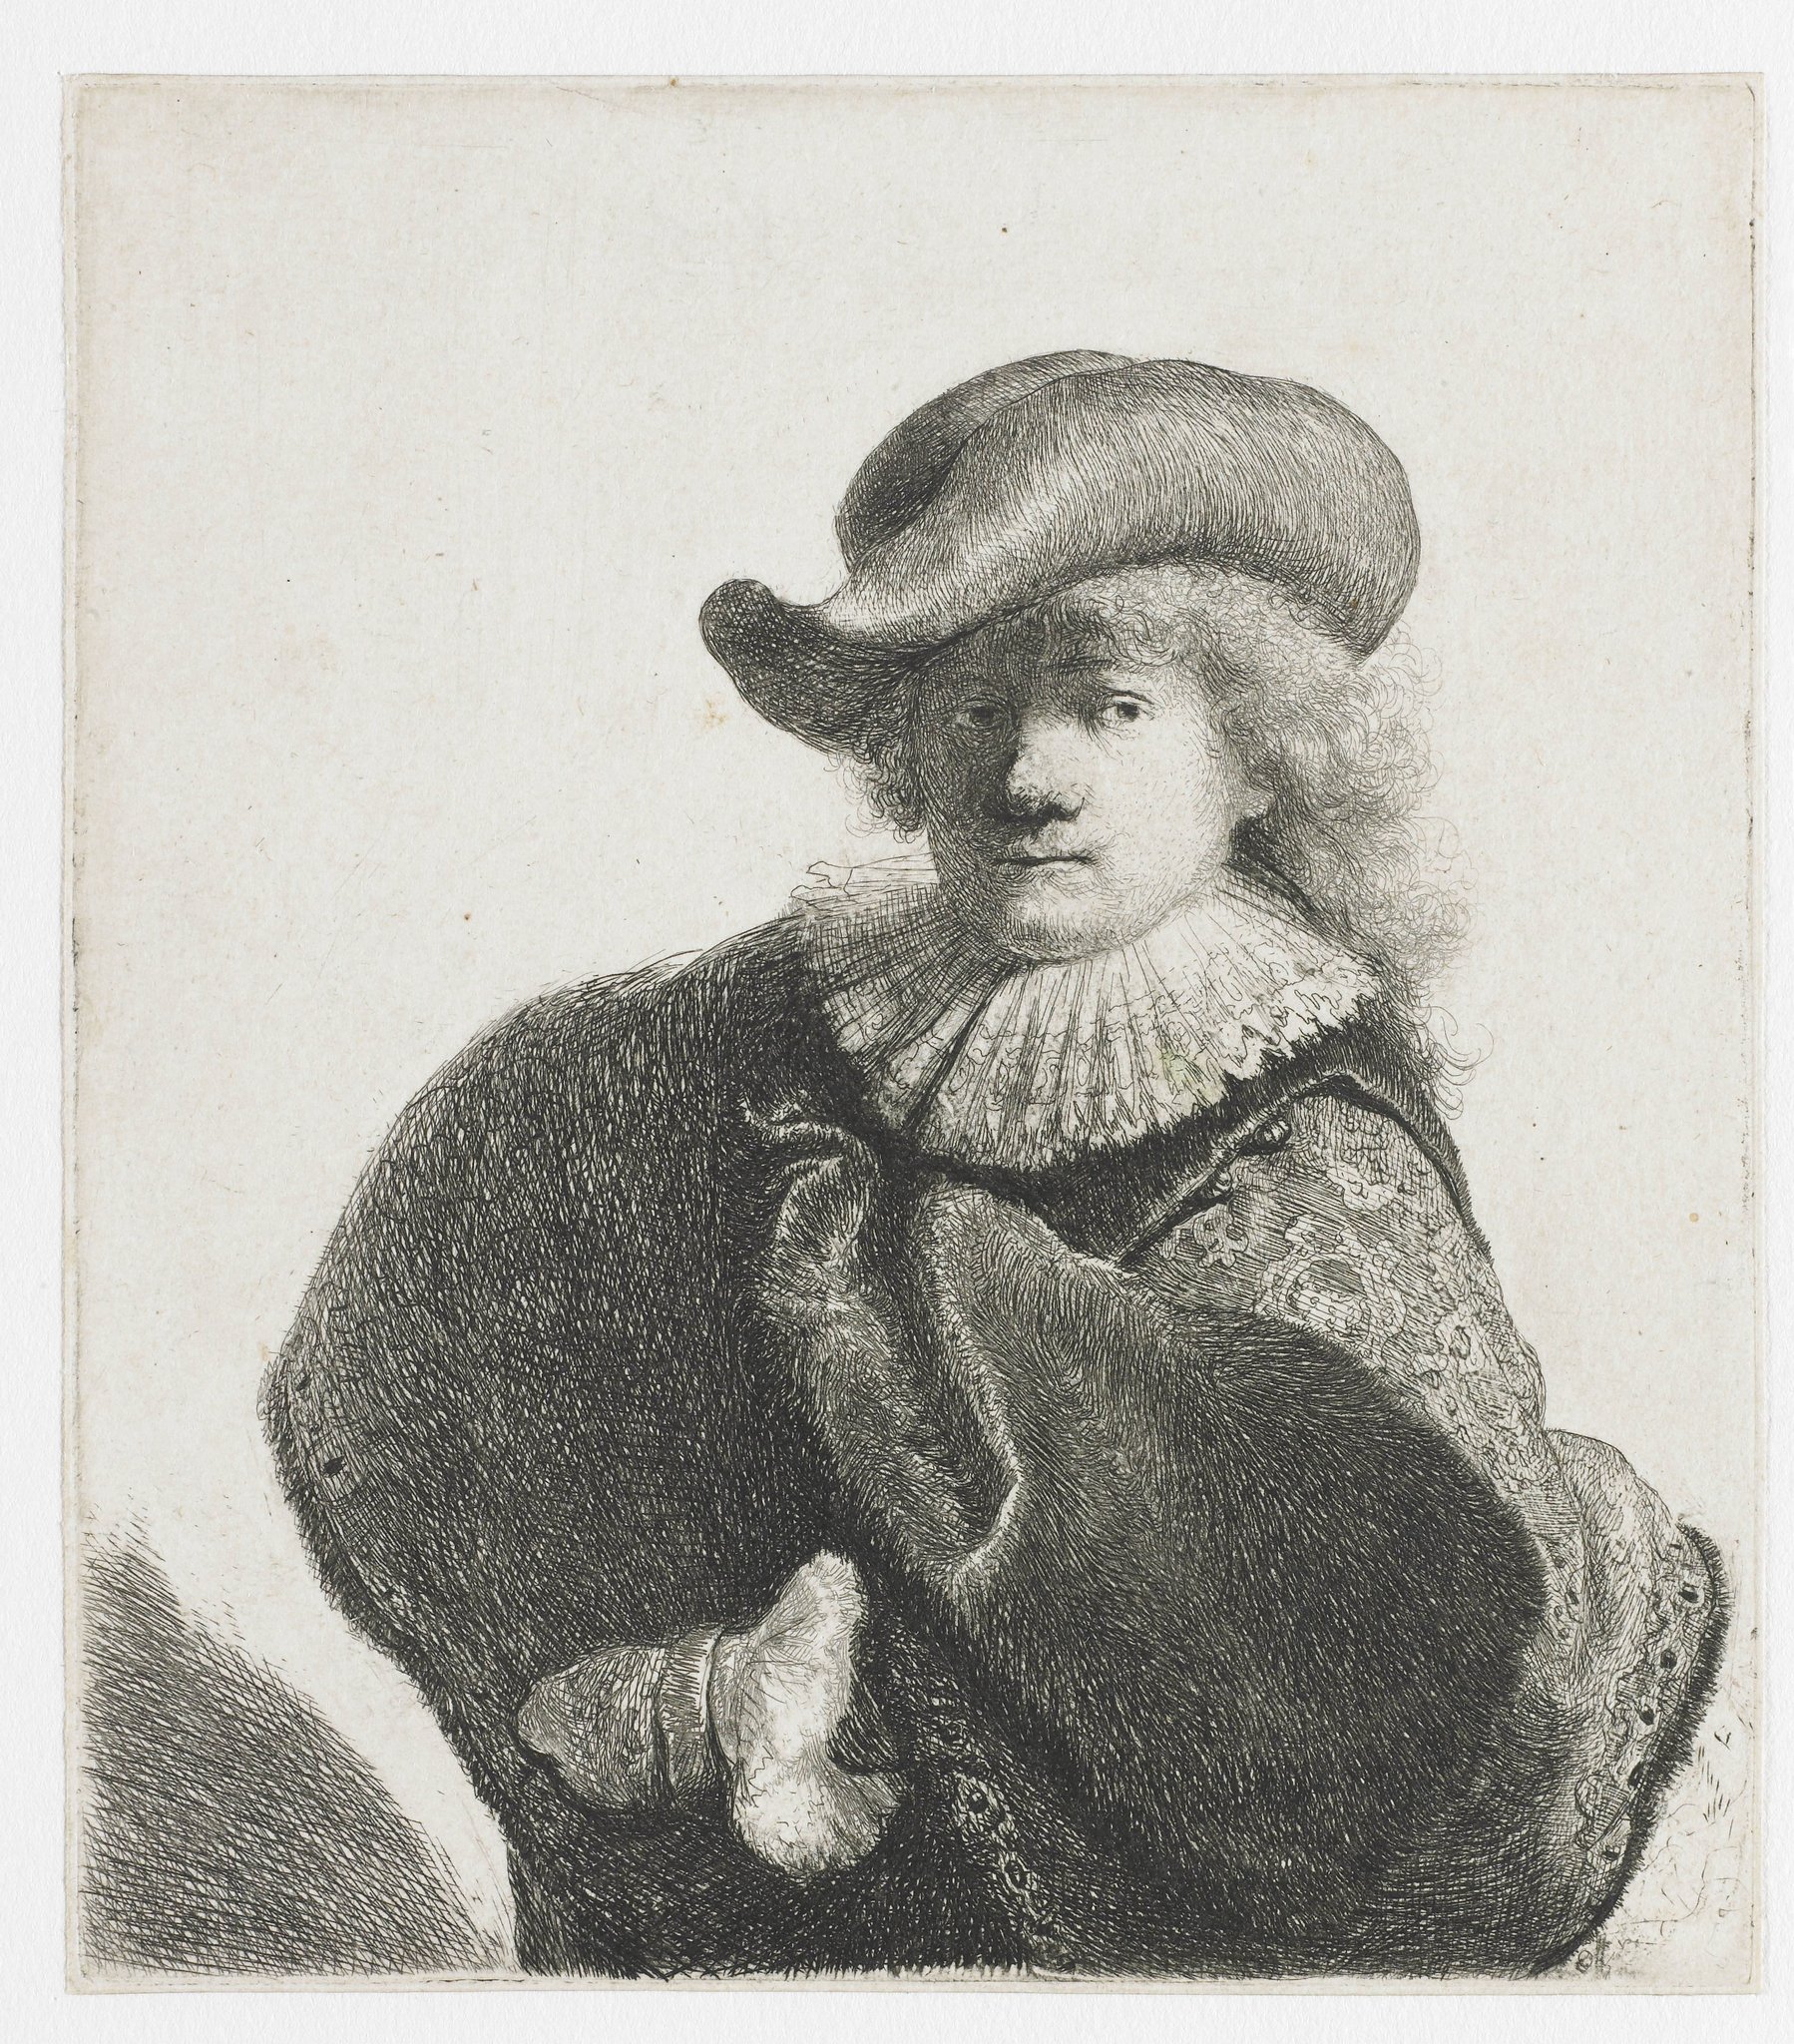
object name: print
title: Self-portrait in a soft hat and a patterned cloak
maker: rembrandt van rijn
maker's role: draughtsman, painter, print maker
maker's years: 1606-1669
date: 1631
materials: paper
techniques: drypoint, etching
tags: leiden, amsterdam, painter, print maker, draughtsman, rembrandt van rijn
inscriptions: collector's mark: Lugt 2228, collector's mark: Lugt 1419